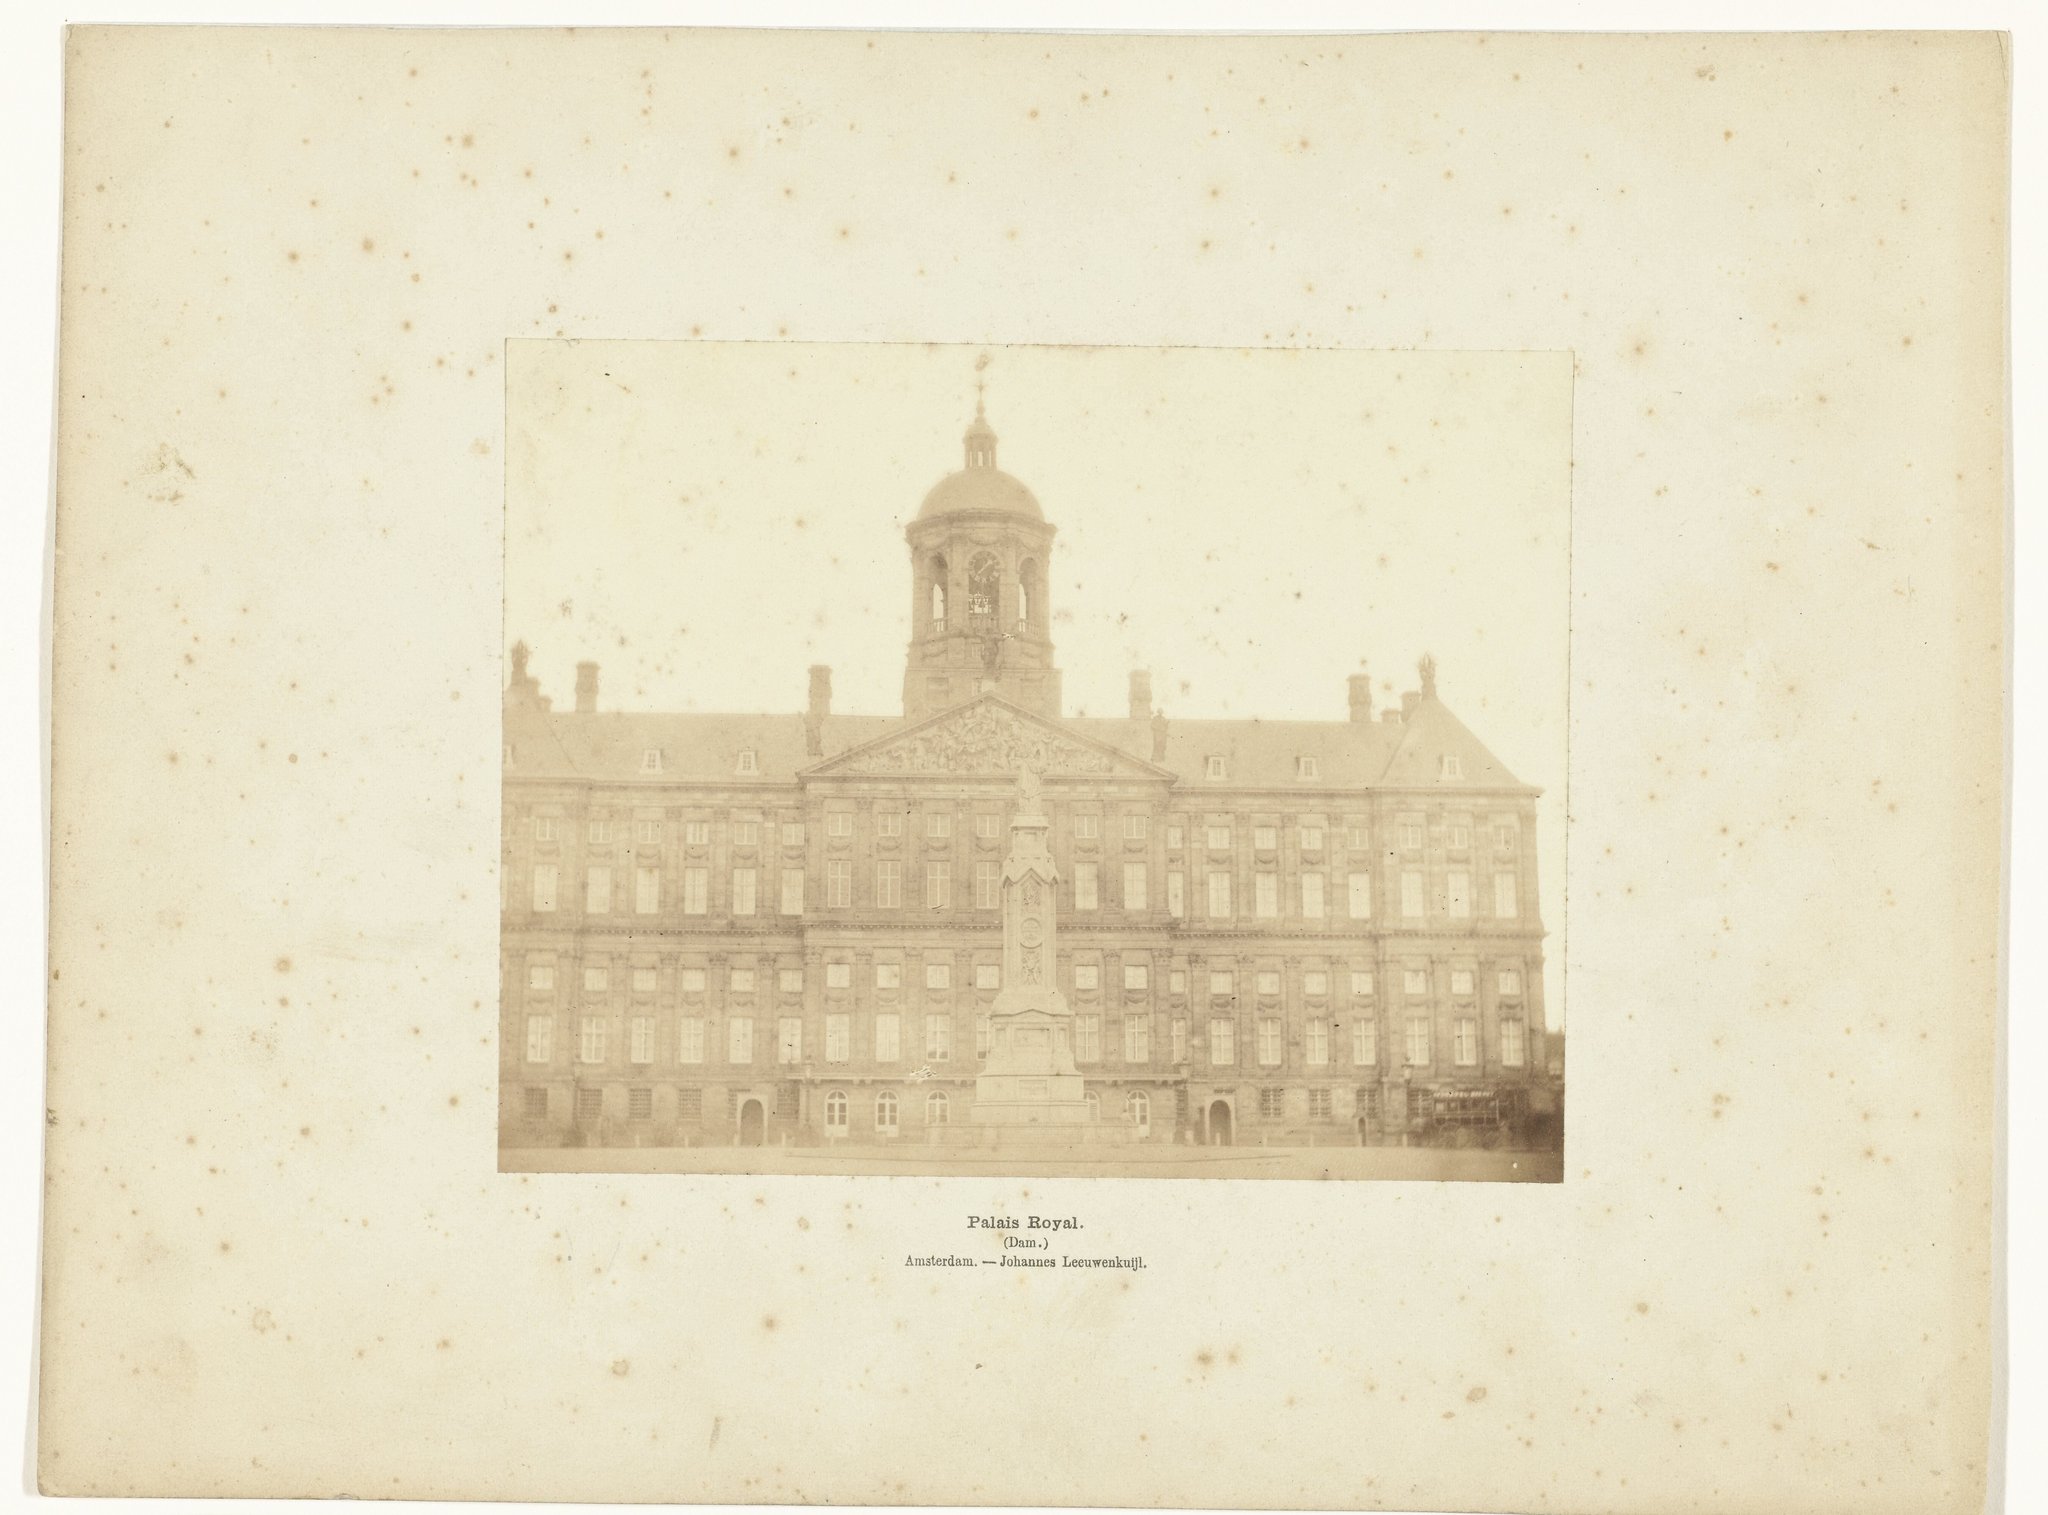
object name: photograph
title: Het Paleis op Dam recht van voren gezien, met Naatje op de voorgrond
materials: cardboard, paper, photographic support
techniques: albumen print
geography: amsterdam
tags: palace, townhall, piece of sculpture, reproduction of a piece of sculpture, royal palace of amsterdam, amsterdam